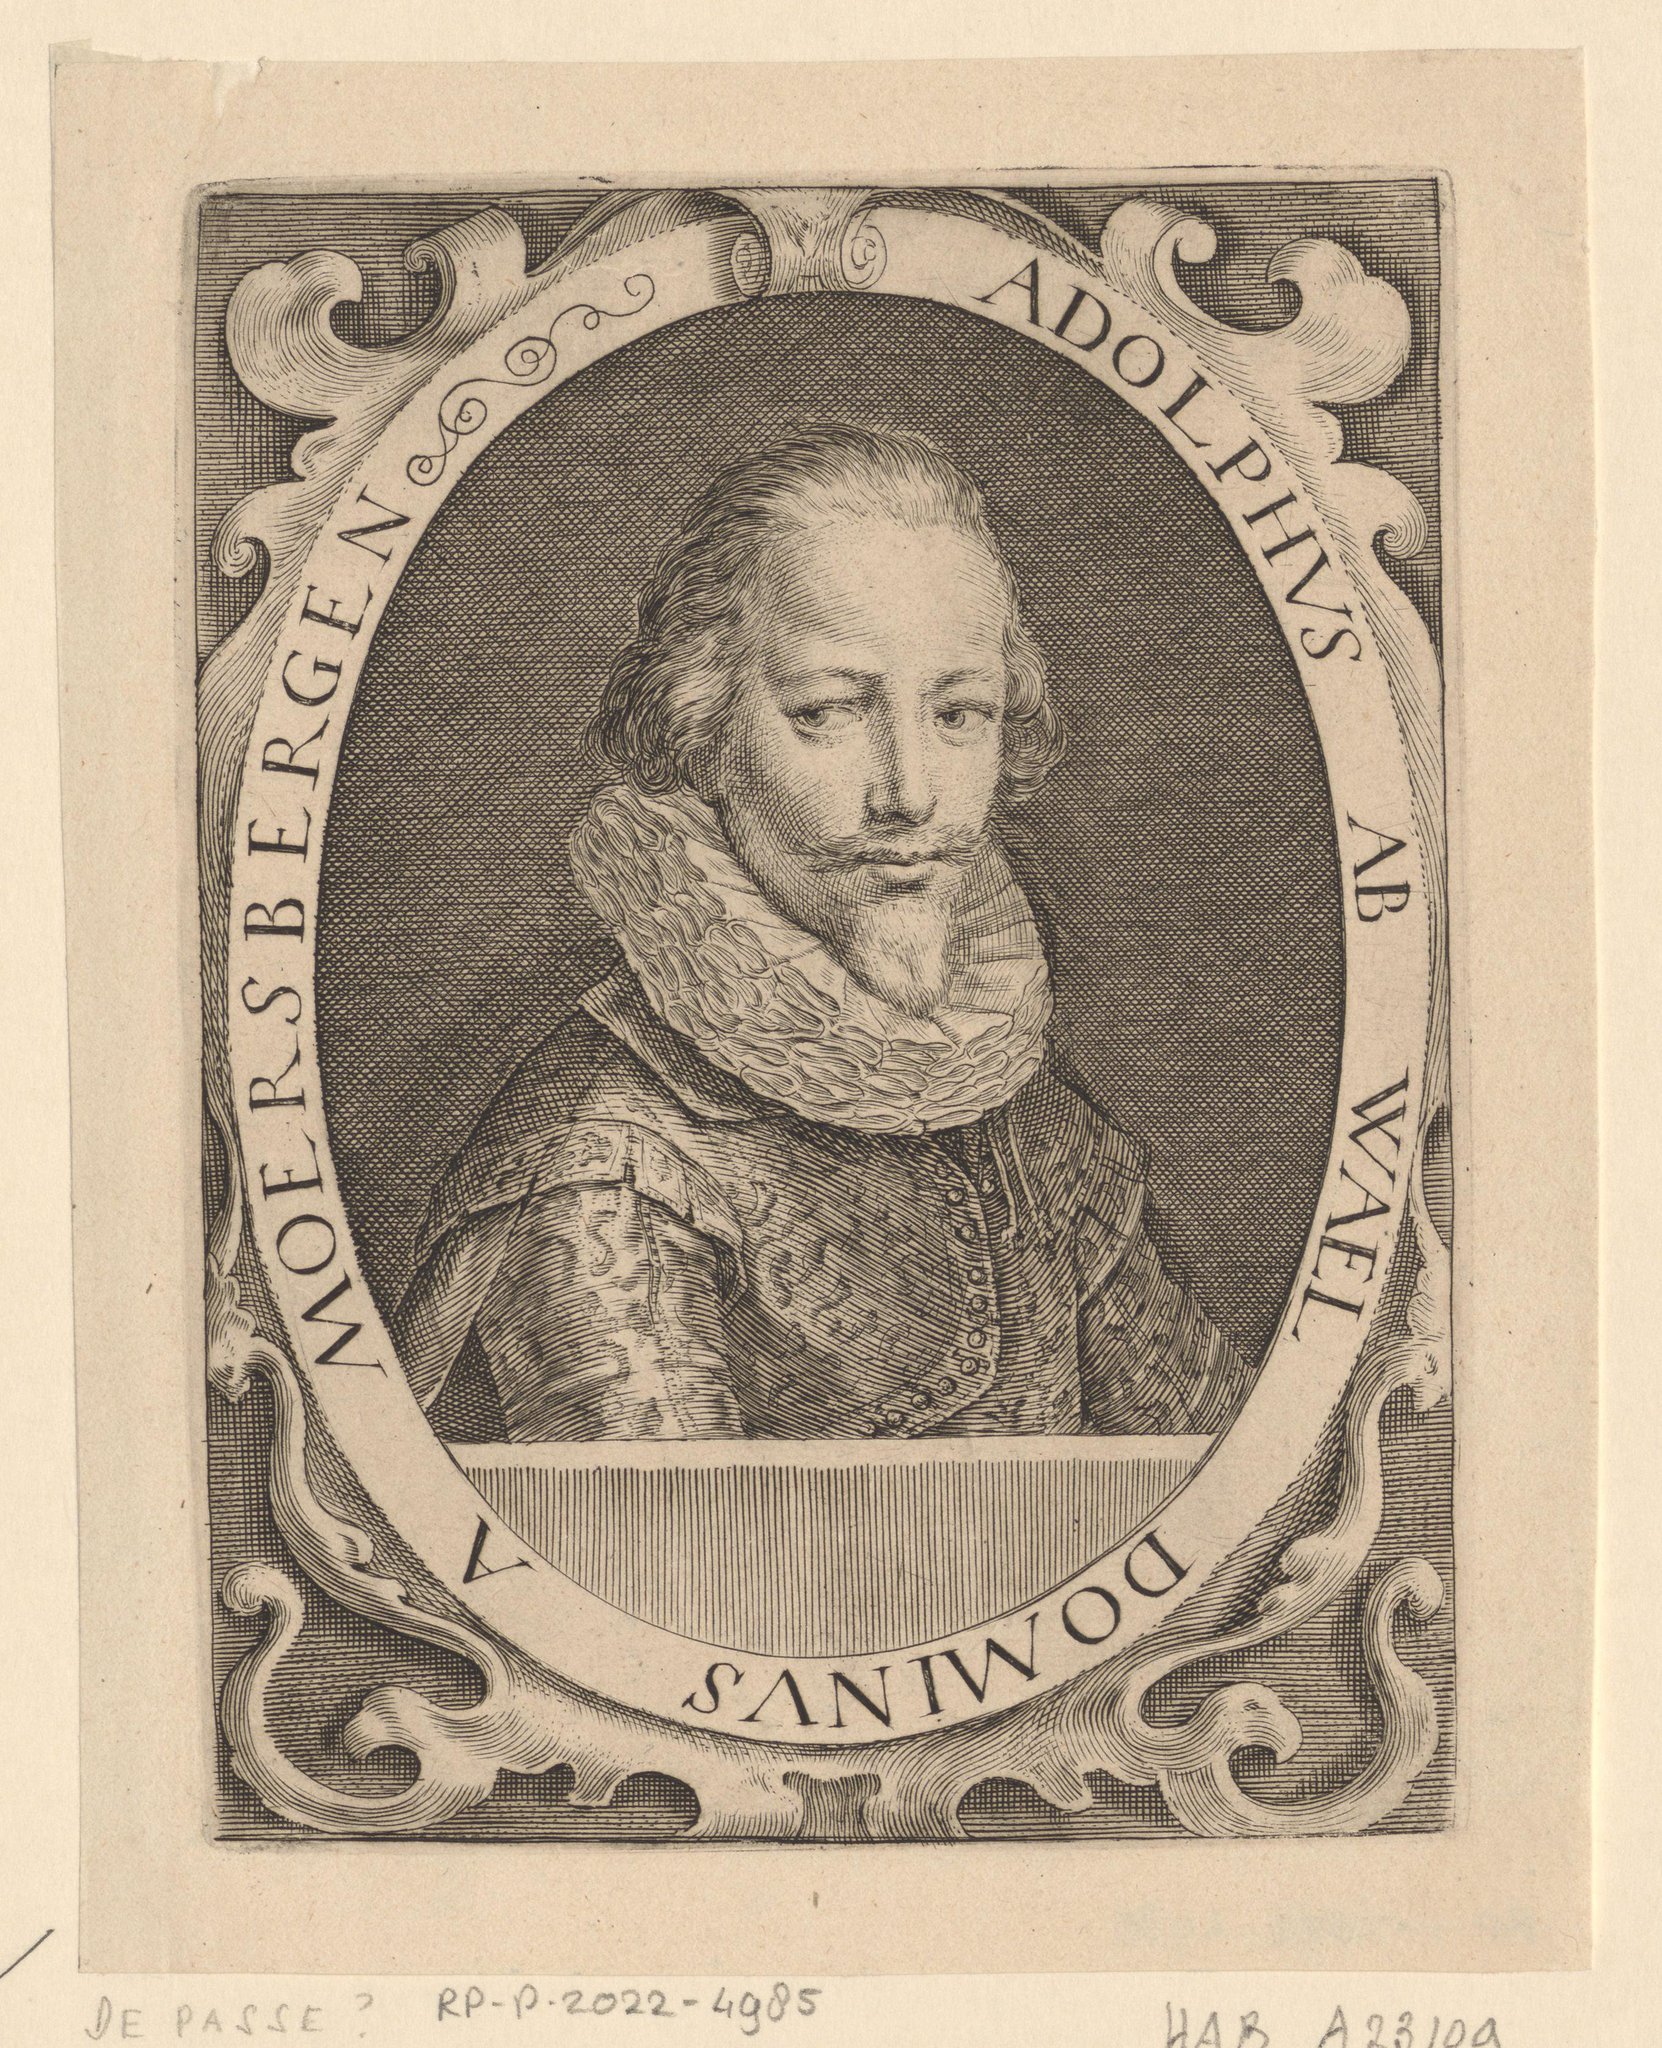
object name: print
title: Portret van Adolf de Wael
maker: crispijn van de passe (i)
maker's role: draughtsman, print maker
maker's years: 1564-1637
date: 1611-1637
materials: paper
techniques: engraving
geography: utrecht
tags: mayor, historical persons